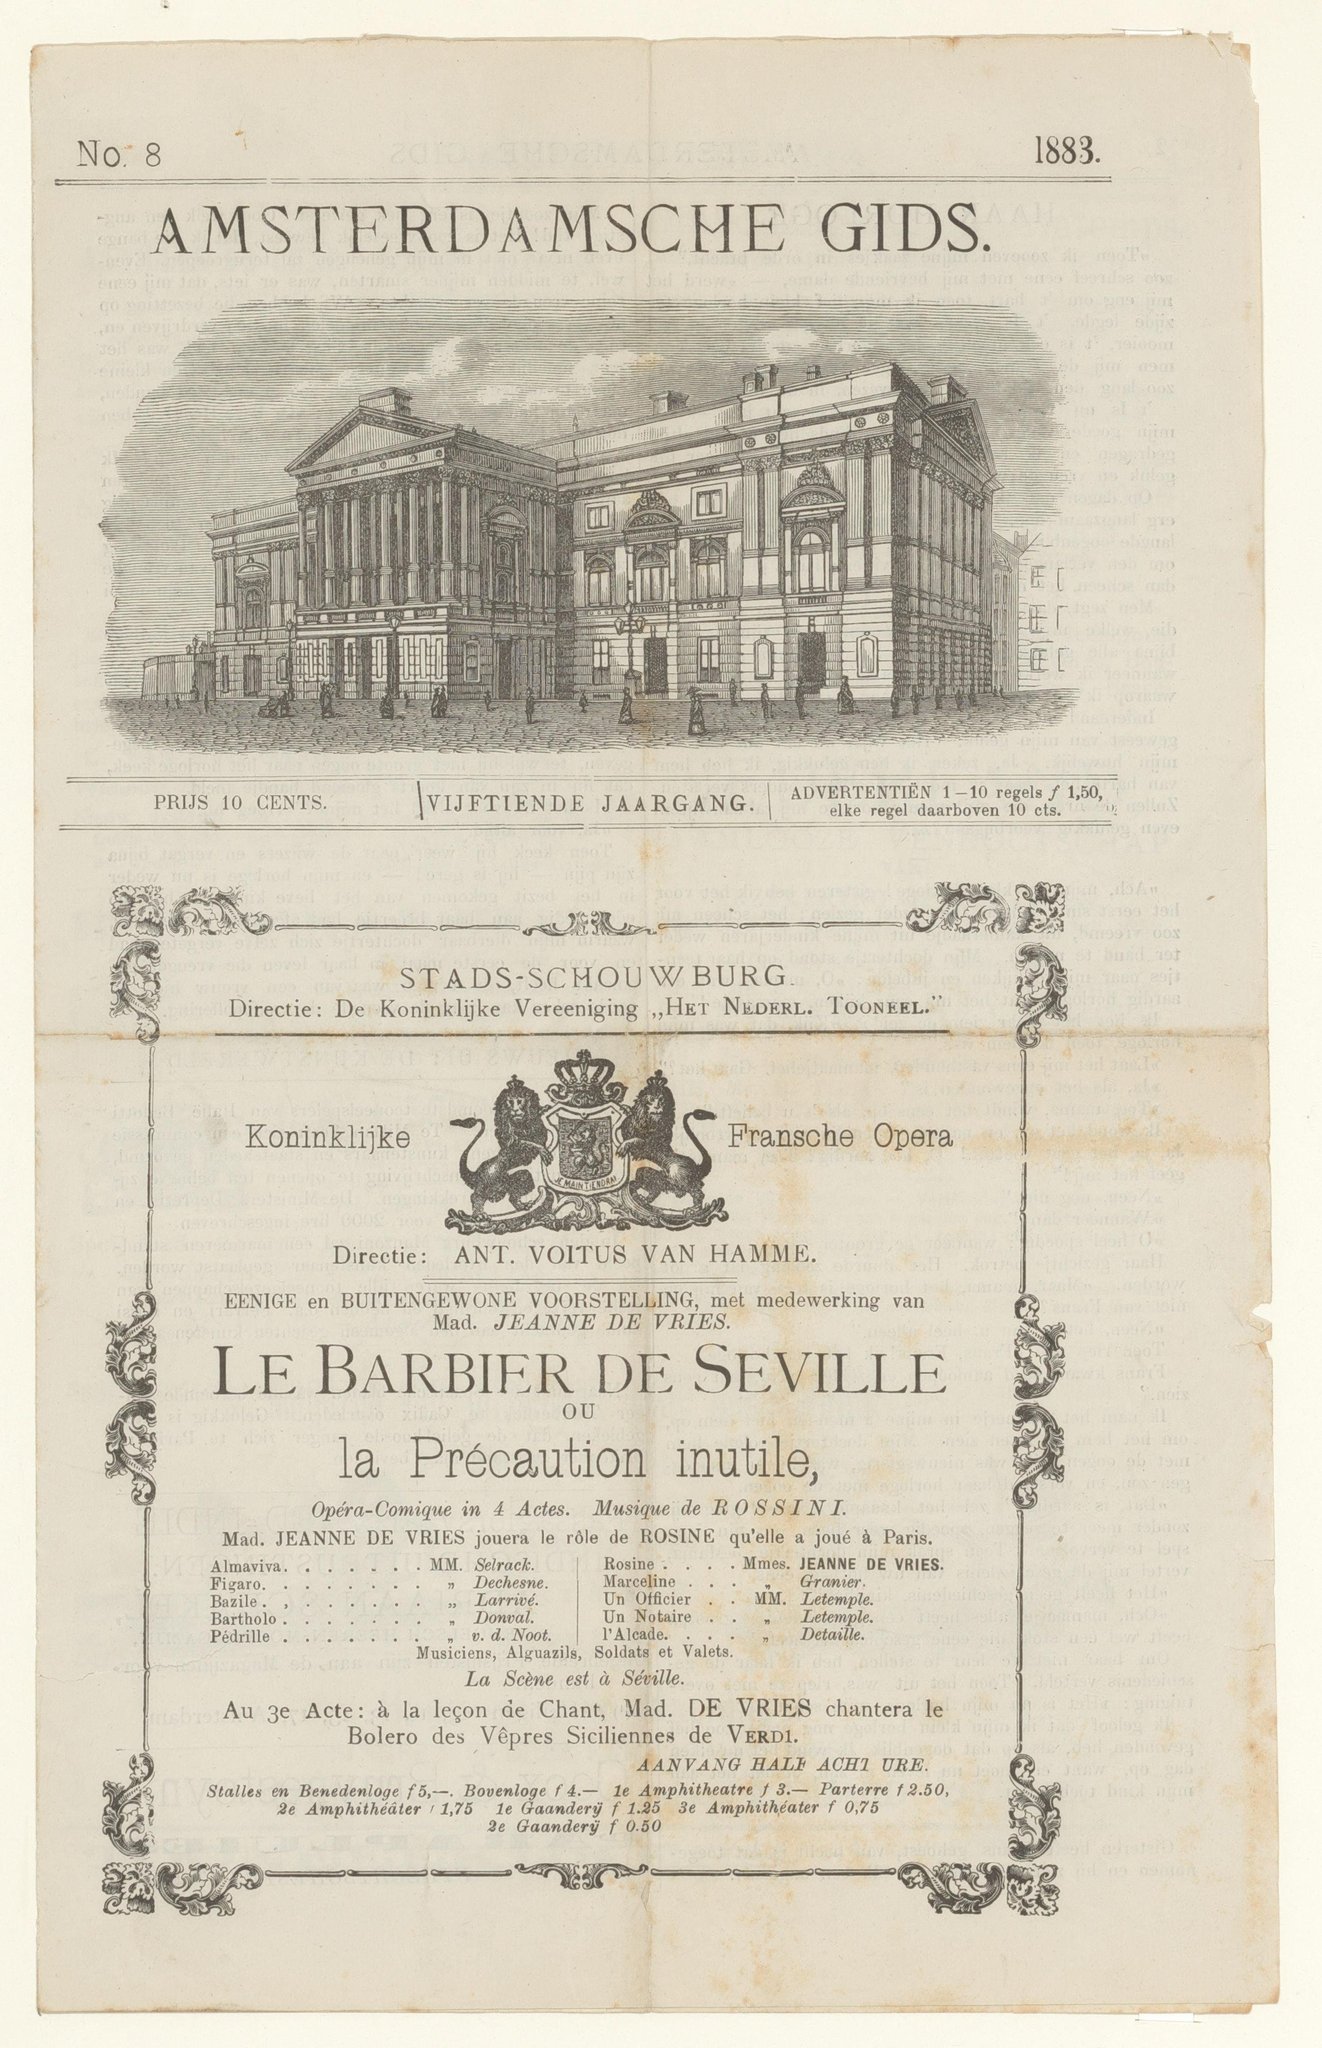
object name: print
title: Amsterdamsche Gids met aankondiging van de voorstelling Le Barbier de Seville, 1883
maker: Anonymous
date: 1883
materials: paper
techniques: letterpress printing, engraving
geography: amsterdam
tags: theatre, theatrical performance, advertisement, notice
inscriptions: stamp, collector's mark: Lugt 1641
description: Een in elkaar gevouwen blad vormt vier pagina's. Op de eerste pagina een aankondiging van de aankomende voorstelling Le Barbier de Seville in de Stadsschouwburg in 1883. Op de overige pagina's advertenties. Linksboven genummerd: No. 8. Onderwerpsrubrieken binnen de Atlas Zeden en Gewoonten: Tooneel, Toneelprogramma’s.